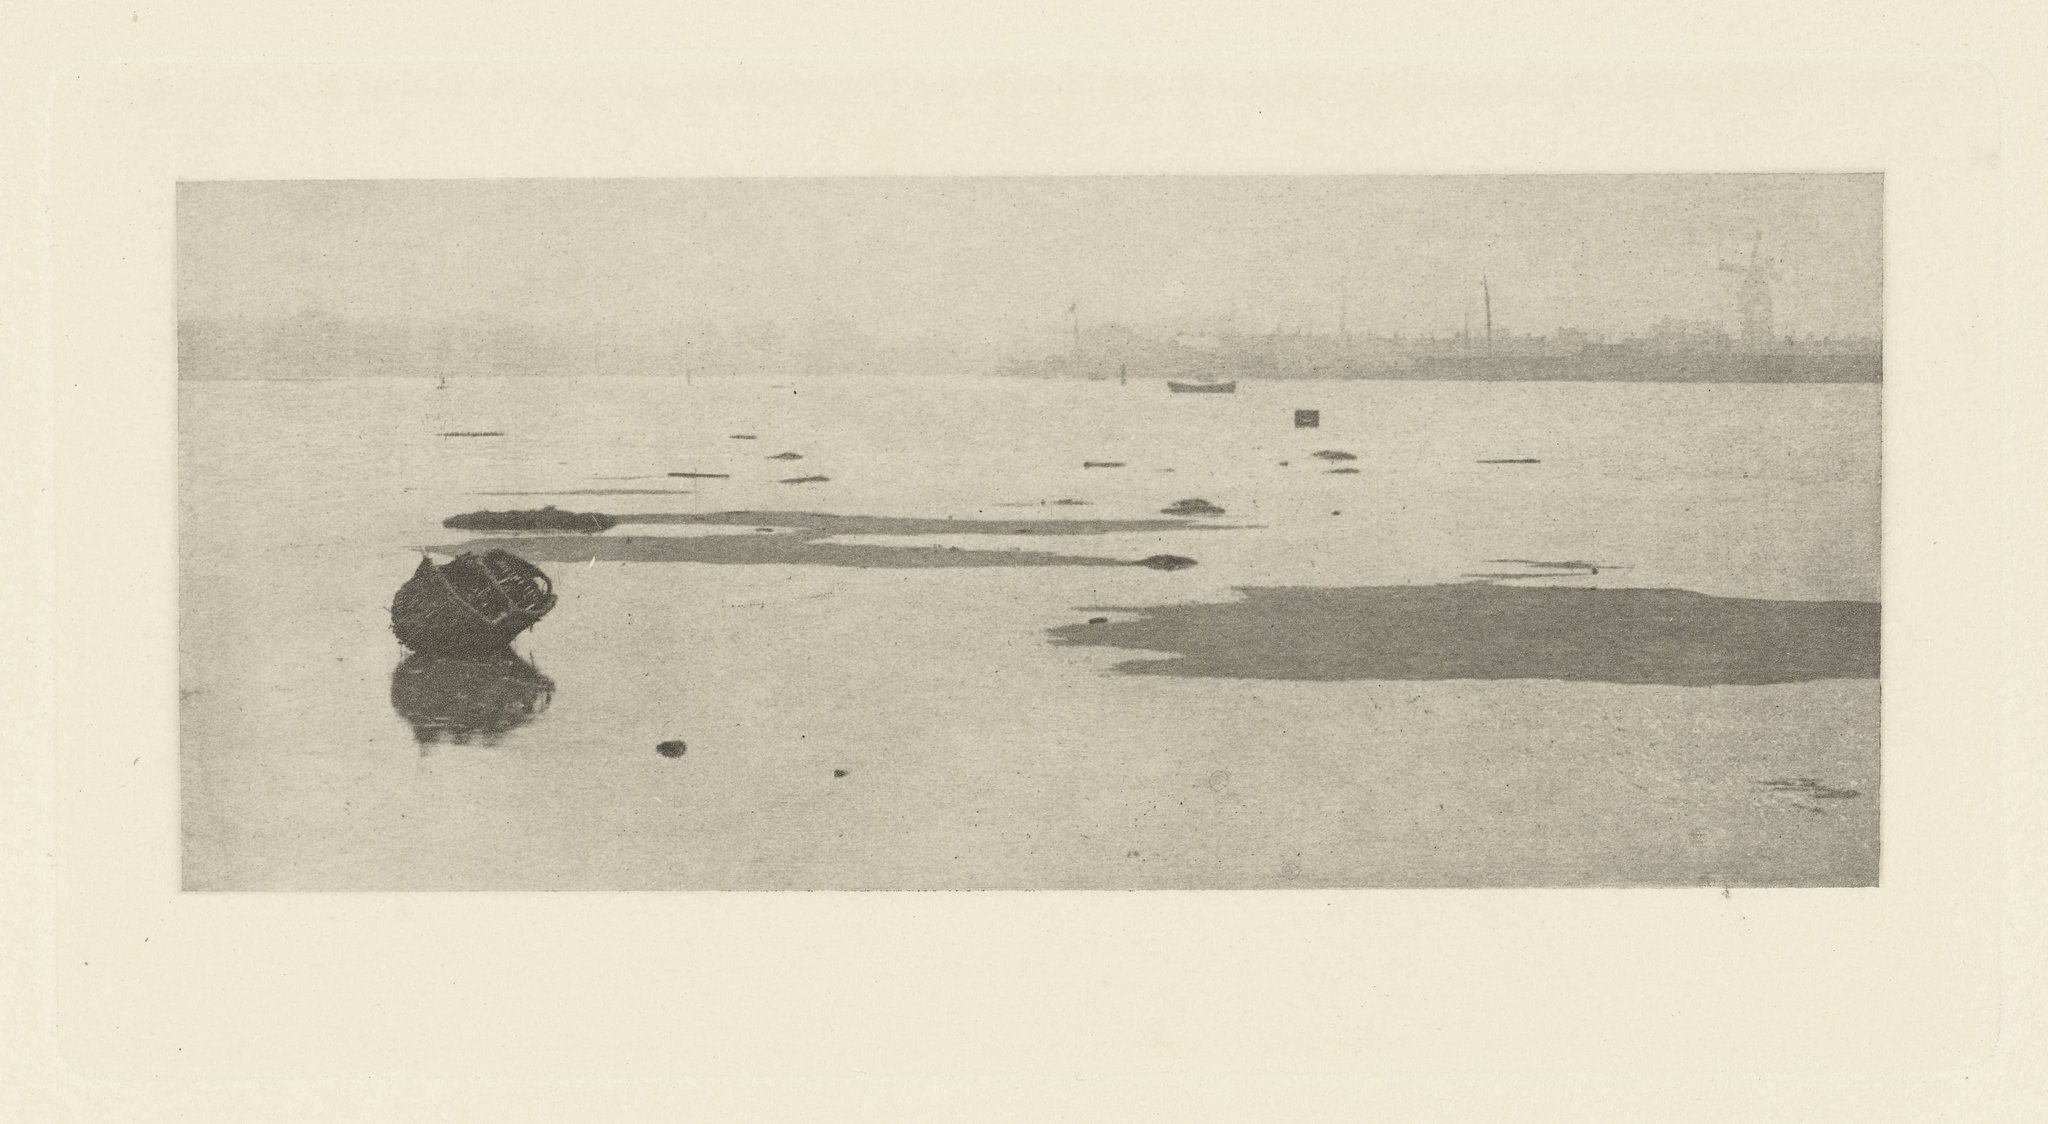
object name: photomechanical print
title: Breydon bij eb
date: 1887-1890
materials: paper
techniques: photoaquatint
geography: london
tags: landscapes with waters, waterscapes, seascapes (in the temperate zone)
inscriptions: inscription: ‘PLATE II/ LOW WATER ON BREYDON/ To face Chapter I’